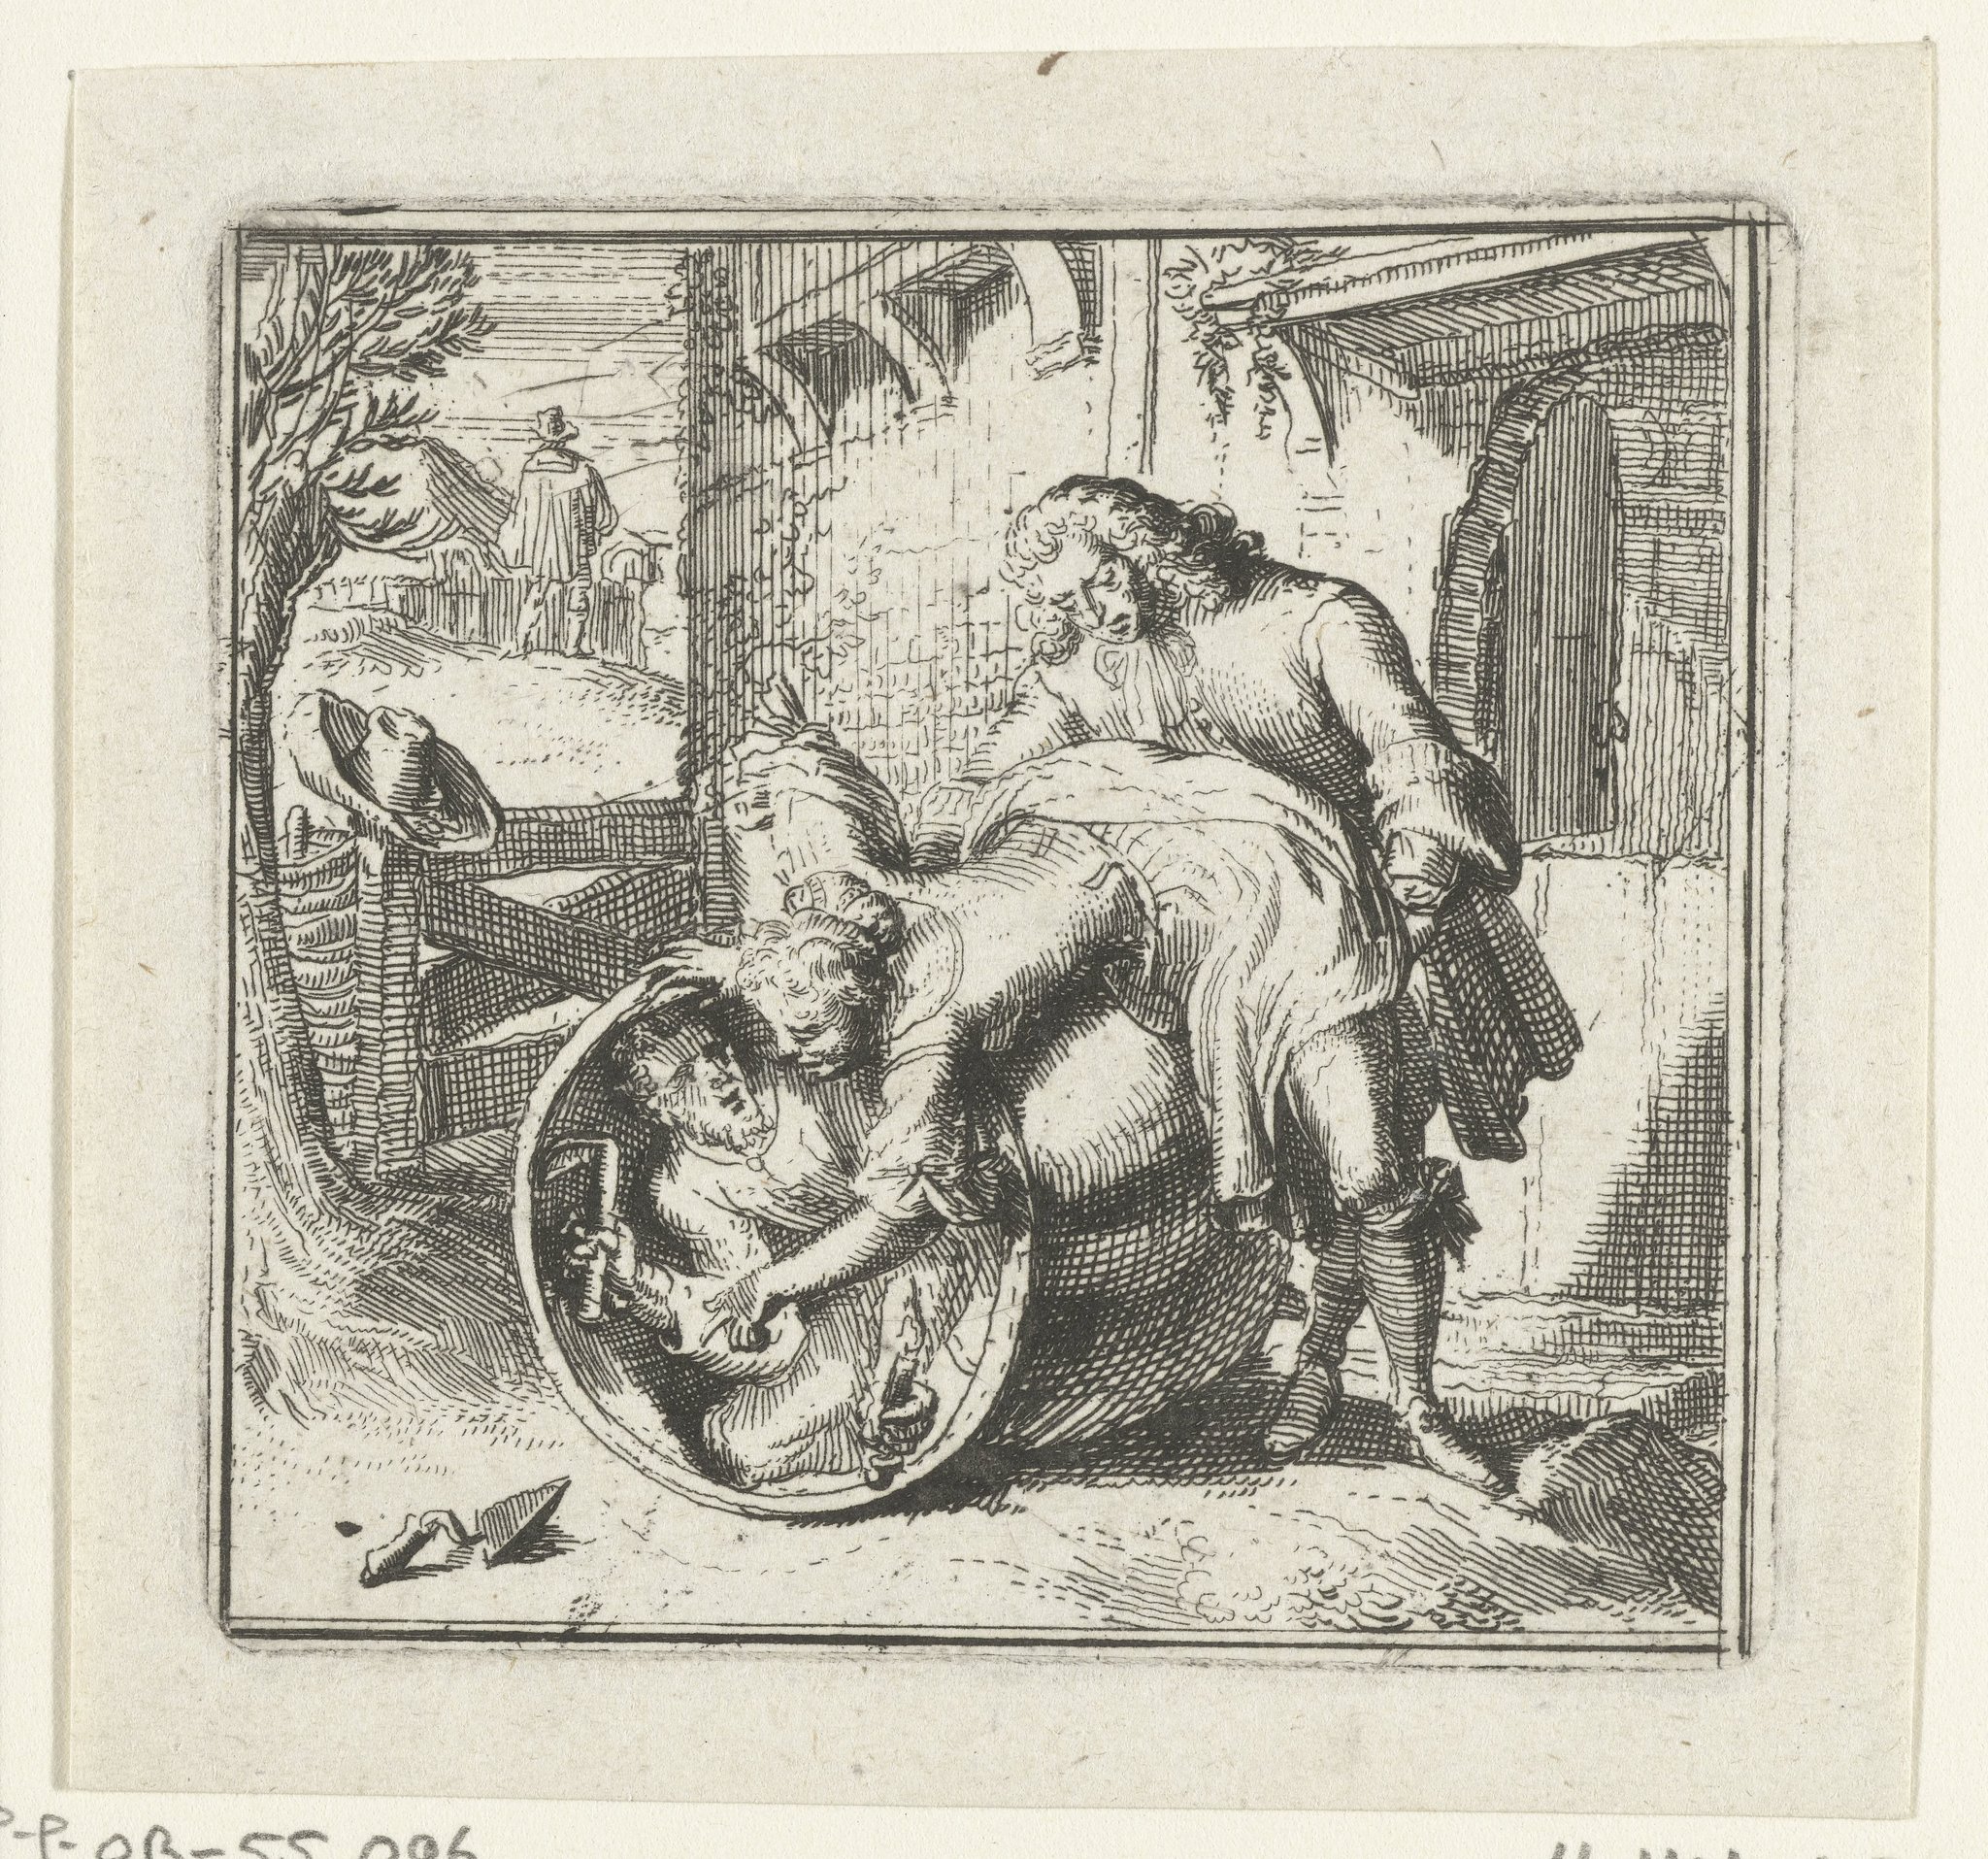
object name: print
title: Illustratie voor de Decamerone van Boccaccio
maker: romeyn de hooghe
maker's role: draughtsman, goldsmith, painter, print maker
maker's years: 1645-1708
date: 1697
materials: paper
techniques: etching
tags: (scenes from) specific works of literature: boccaccio, decamerone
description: Illustratie voor de Decamerone van Boccaccio, historie LXII. Perronella staat voorover gebogen om haar man, die in een vat zit, aanwijzingen te geven. Zij houdt ondertussen haar rok omhoog voor haar minnaar die achter haar staat.